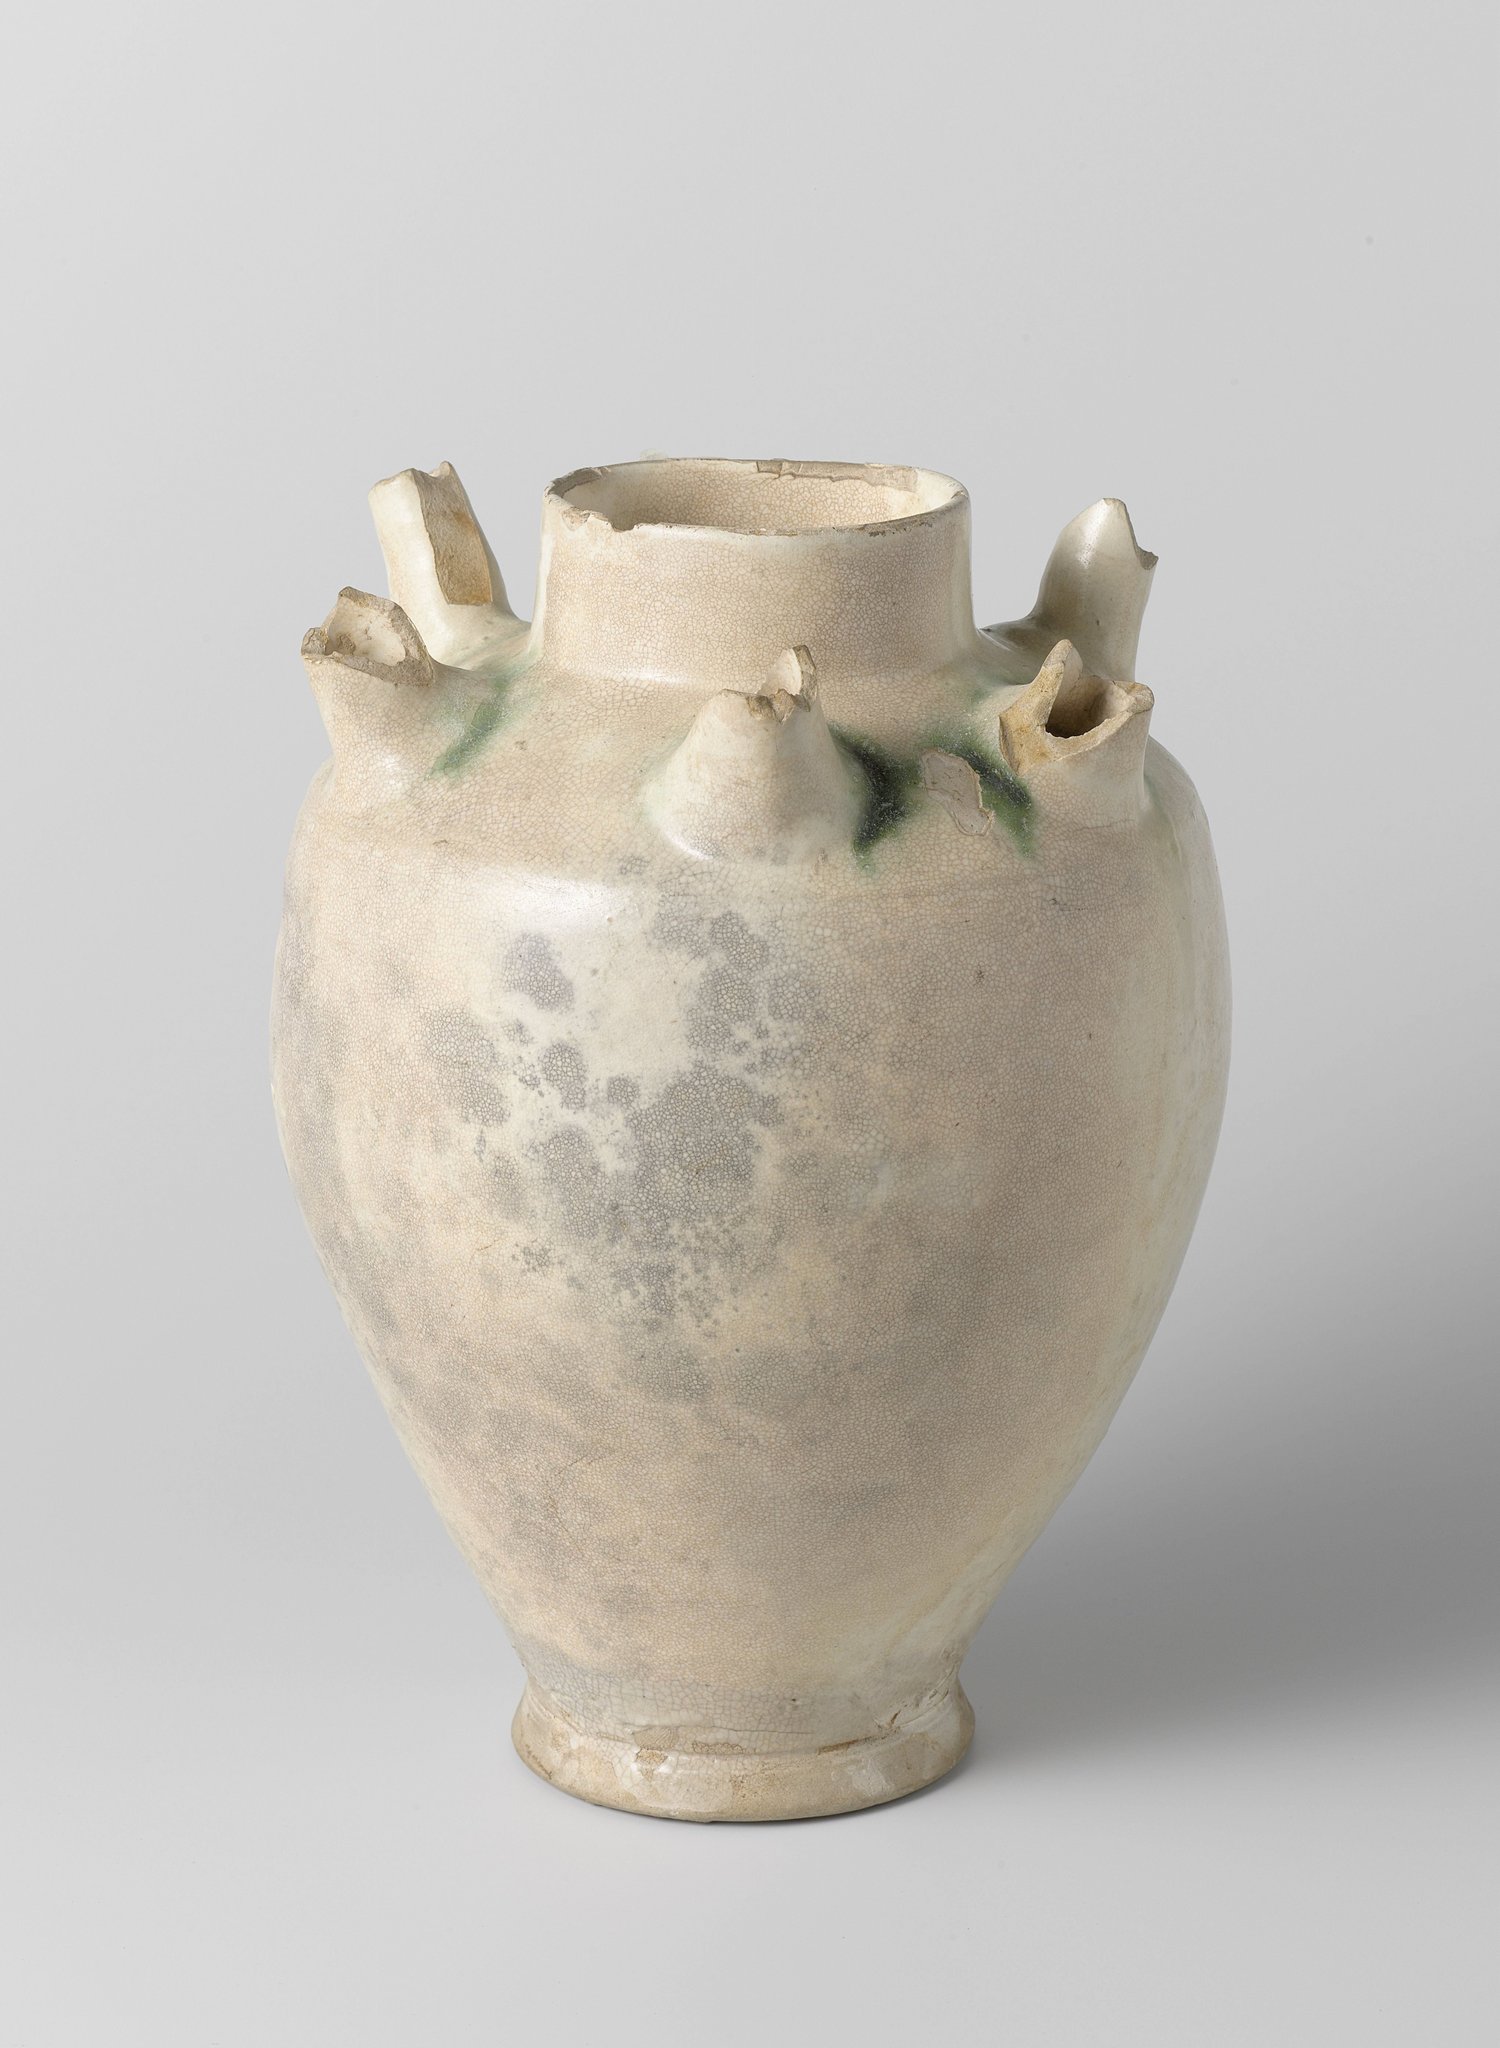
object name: vase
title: Ovoid vase with six tubes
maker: Anonymous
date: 907-960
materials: glaze, stoneware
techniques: firing, forming, turning, vitrification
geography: china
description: Eivormige vaas van steengoed, bedekt met een grijsgroen, iets gecraqueleerd glazuur. Vanuit de schouder zes afgebroken tuiten. Enkele chips in de rand en in de voet.